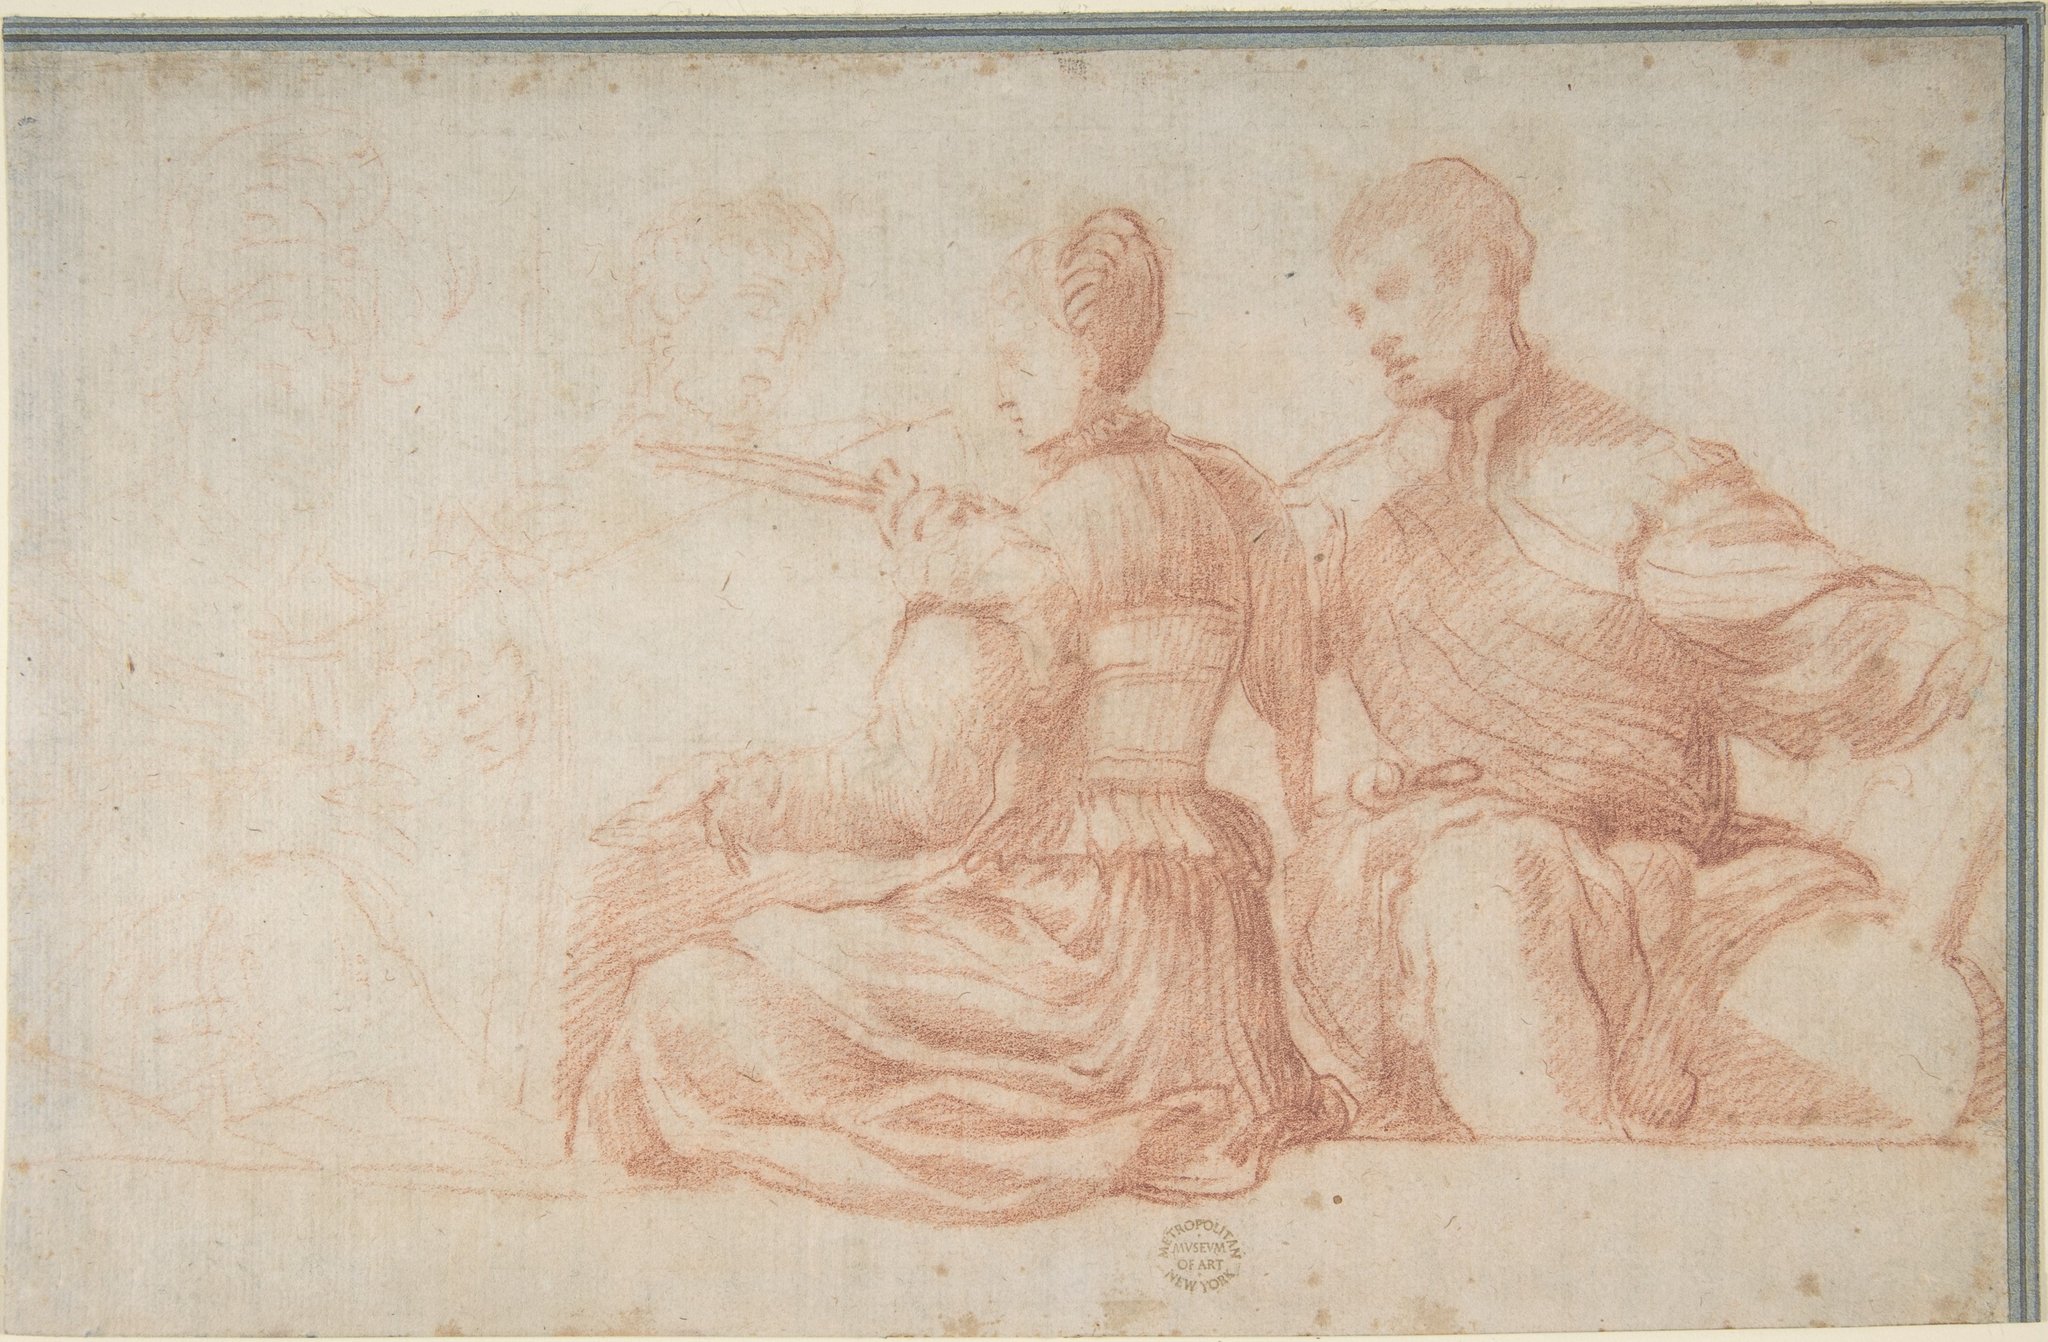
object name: drawing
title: A Frieze Portraying a Music Party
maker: niccolò dell' abate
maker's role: artist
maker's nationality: italian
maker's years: 1509-1571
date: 1512-1571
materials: chalk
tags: men,women